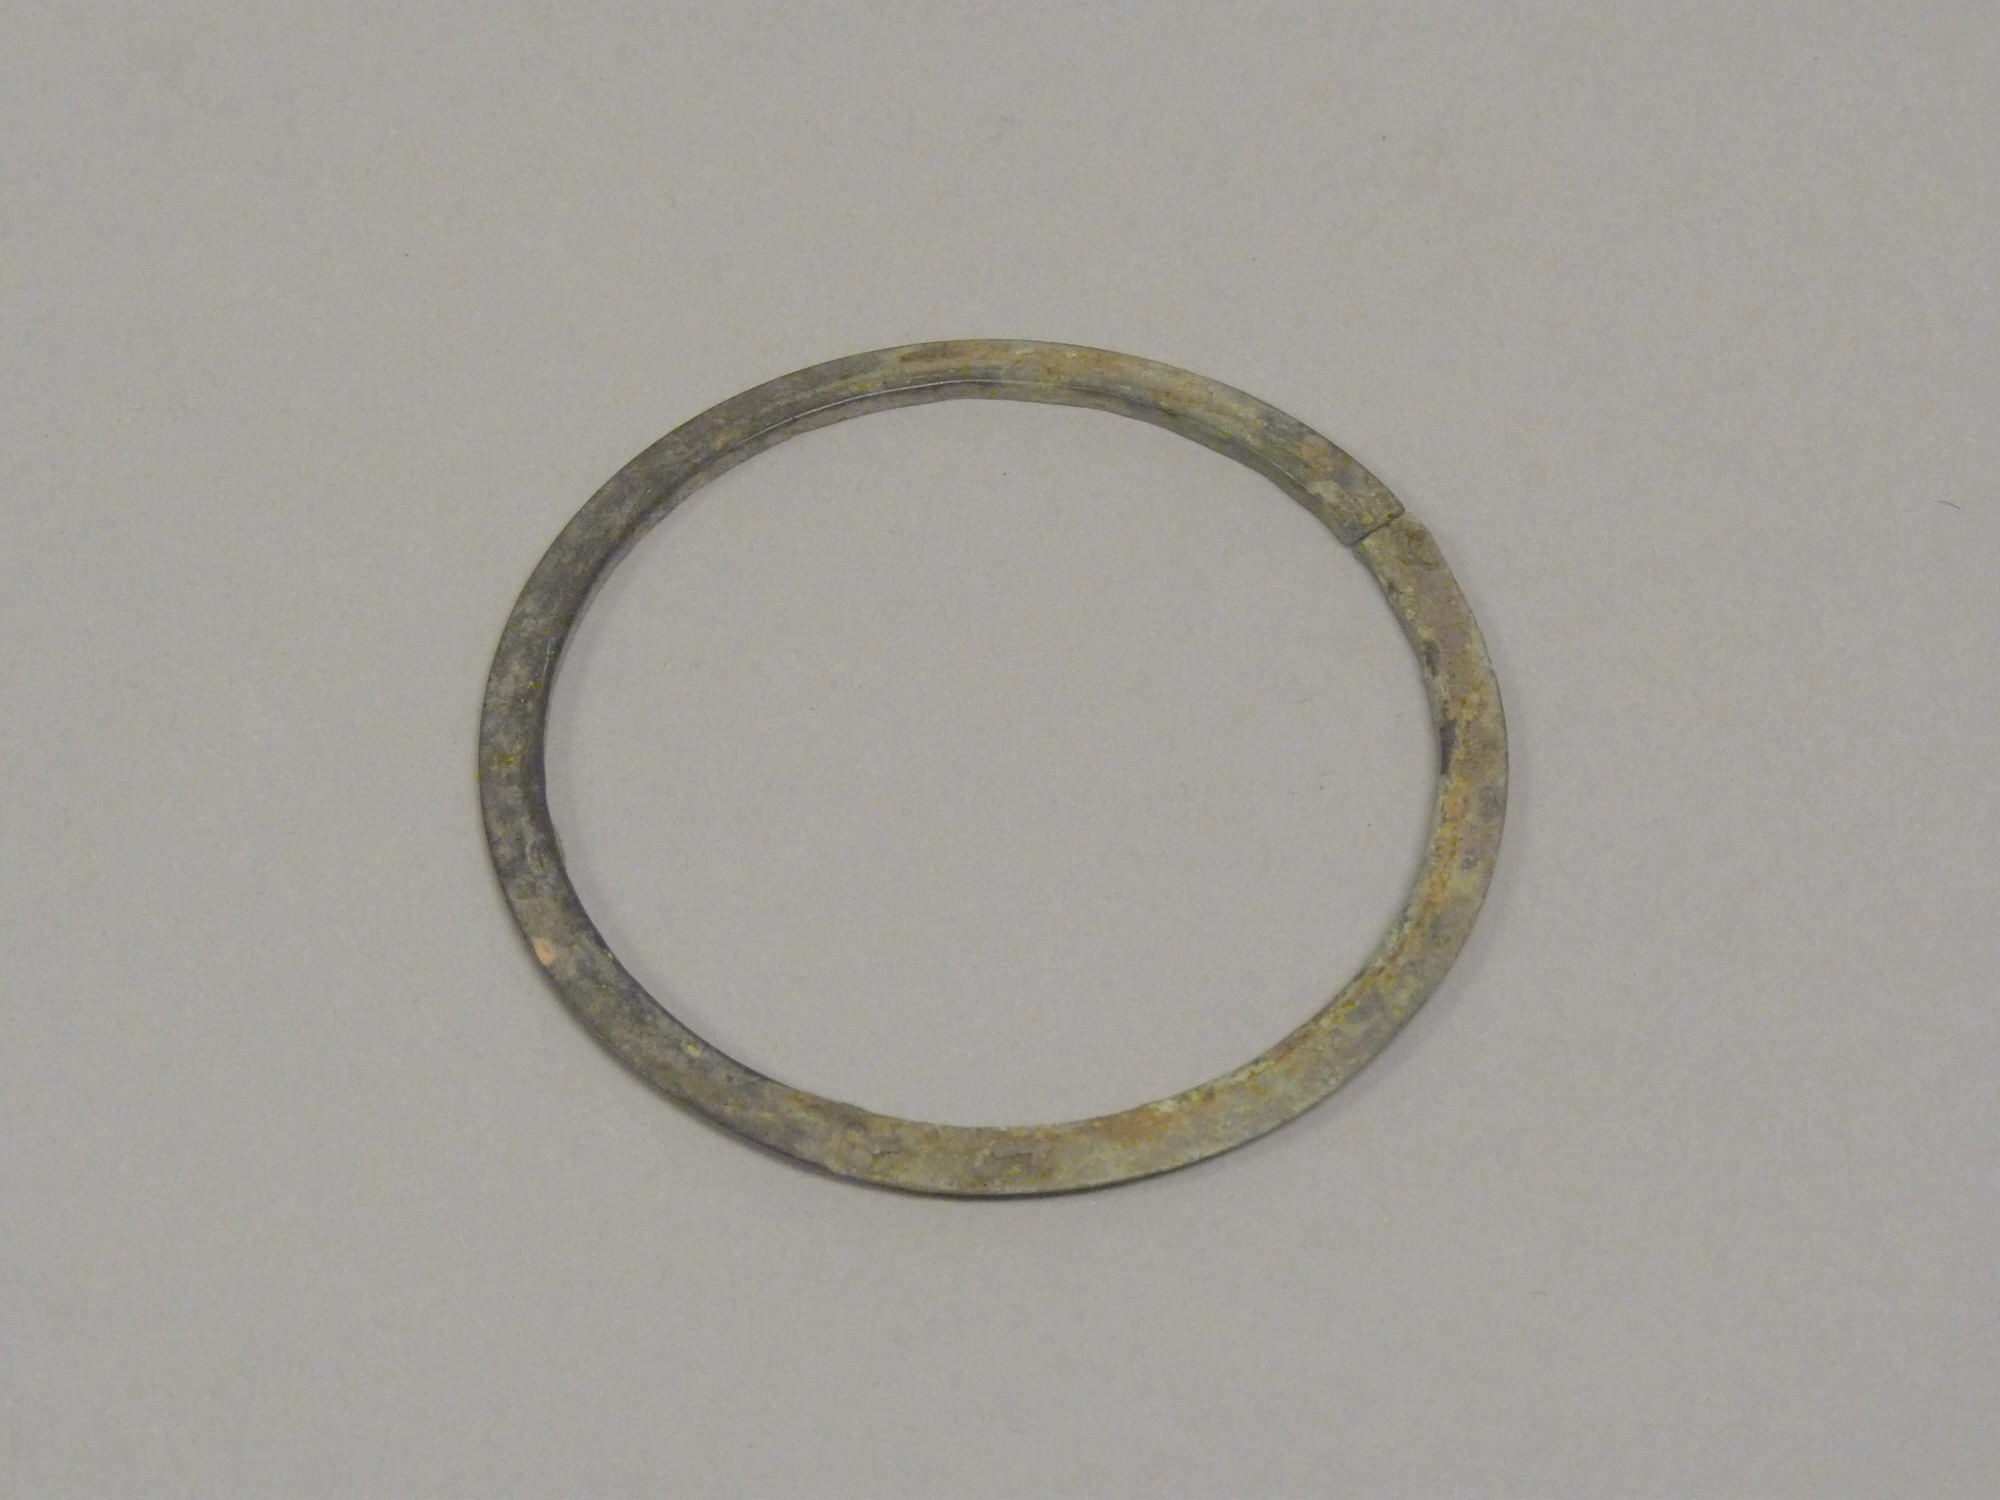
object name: bangle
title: Bangle with Circular Motifs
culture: thai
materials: bronze